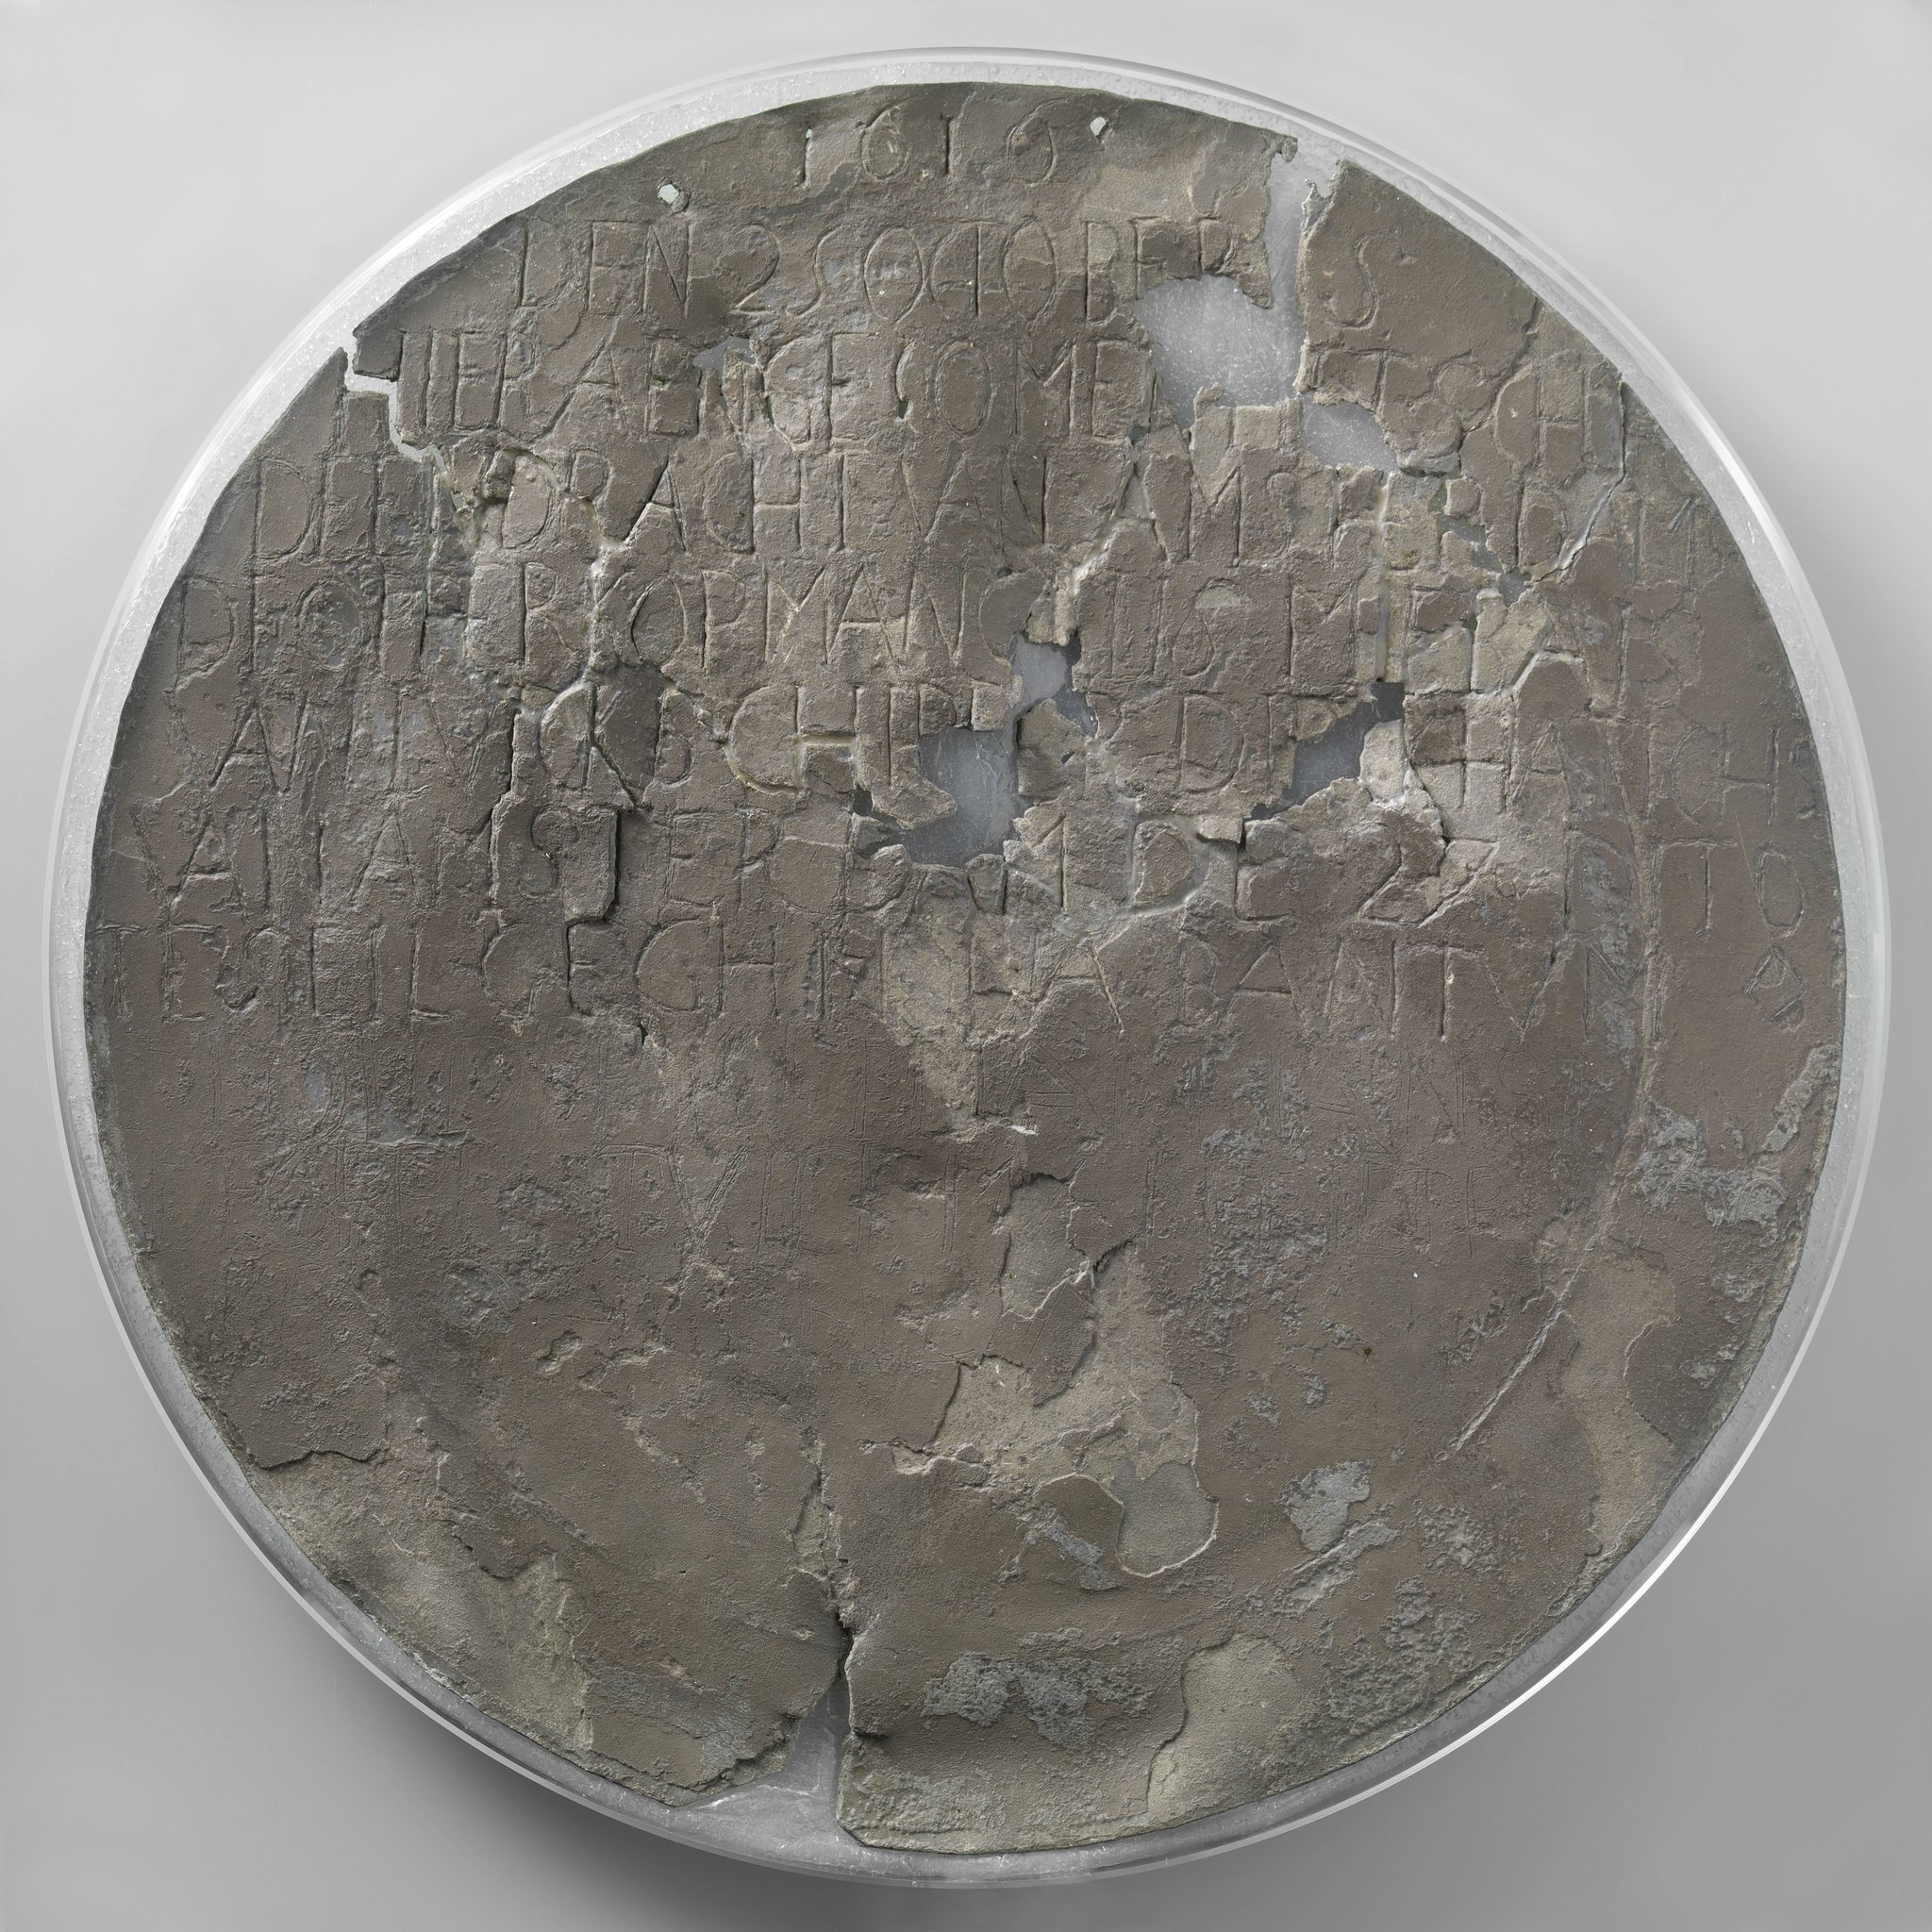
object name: platter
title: Dirck Hartogh dish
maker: Anonymous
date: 1616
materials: tin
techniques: casting, engraving, striking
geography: dirk hartog island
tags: amsterdam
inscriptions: quality mark, quality mark, inscription and date: ‘1616 / DEN 25 OCTOBER / [I]S HIER AENGECOMEN HET SCHIP / DEENDRACHT VAN AMSTERDAM / DE OPPERKOPMAN GILLIS MIEBAIS / VAN LVICK SCHIPPER DIRCK HATICHS / VAN AMSTERDAM DE 27 DITO / TE SEIL GEGHN NA BANTVM / DE ONDER[KO]EPMAN IAN STINS / DE OPPR[S]TVIERMAN PIETR DOOKE / KES[S] VAN BIL’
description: ‘Arrived here on 25 October 1616’ is the message of this flattened pewter dish. En route to Java, VOC captain Dirck Hartogh accidentally happened upon Australia’s west coast. Before sailing on he had the date, the ship’s name and destination, and the names of the most important crewmembers scratched into this dish. He nailed it to a pole, where it hung exposed to the elements until another Dutch captain found and took it along close to 80 years later.